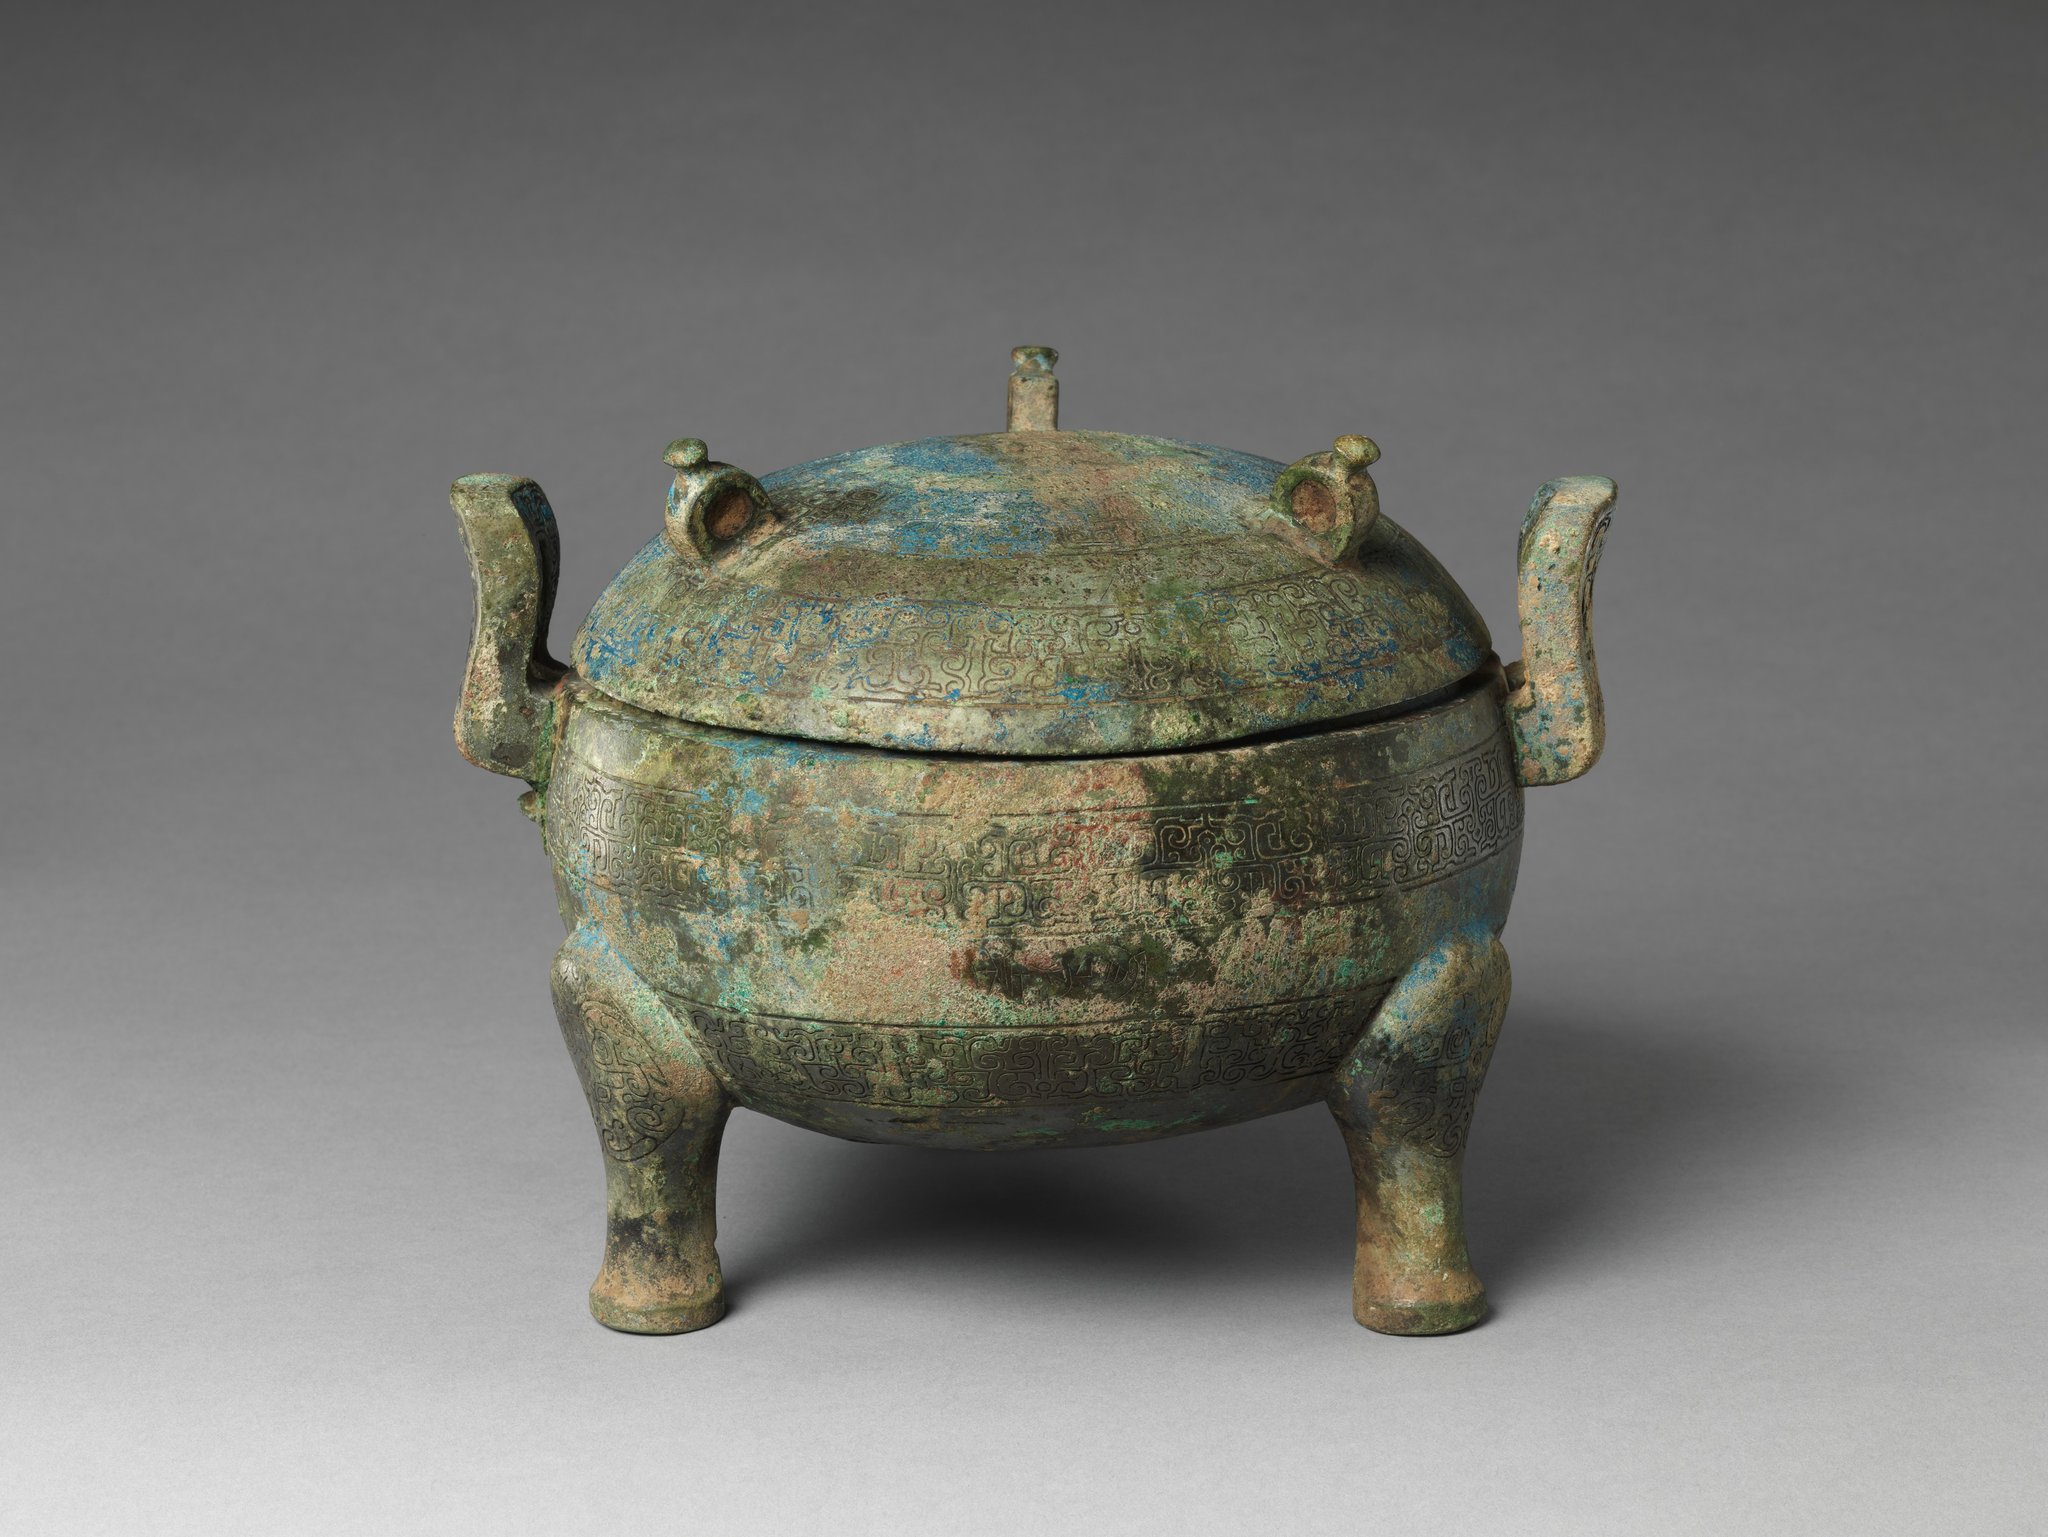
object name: covered vessel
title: Ritual Tripod Cauldron with Cover (Ding)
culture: chinese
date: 500-301 BCE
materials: bronze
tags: cauldrons